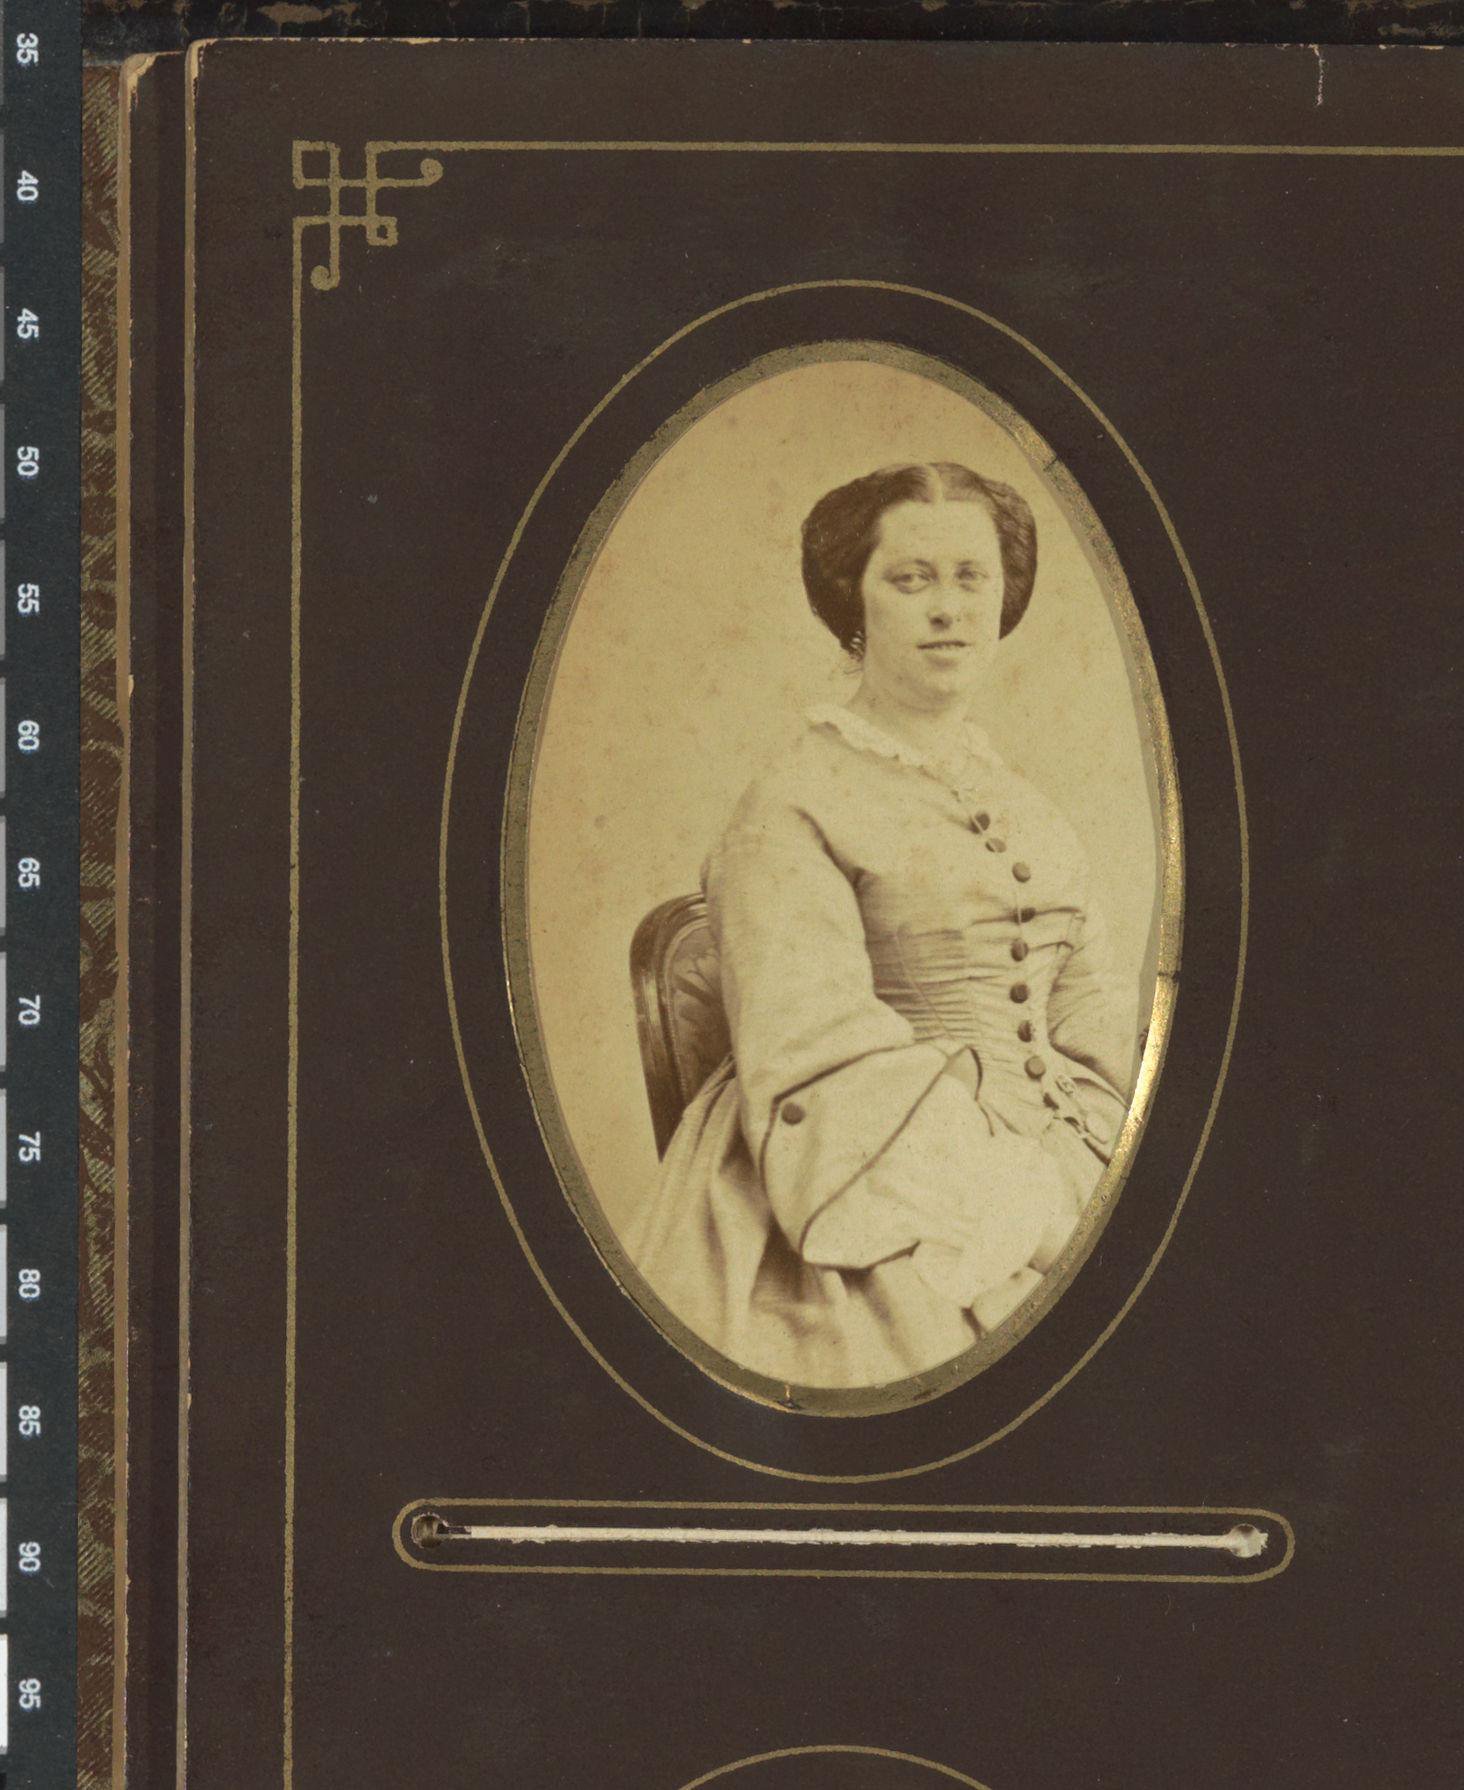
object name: photograph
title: Portret van vrouw in een jurk, zittend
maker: maurits verveer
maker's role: painter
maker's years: 1817-1903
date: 1861-1863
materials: cardboard, paper, photographic support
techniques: albumen print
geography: the hague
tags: adult woman, historical persons - bb - woman, dress, gown, the hague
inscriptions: address: ‘46. Zeestraat 46, vis a vis du Willemspark, La Haye.’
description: Onderdeel van Fotoalbum van de families Matthes, Doorman en Van Thiel.